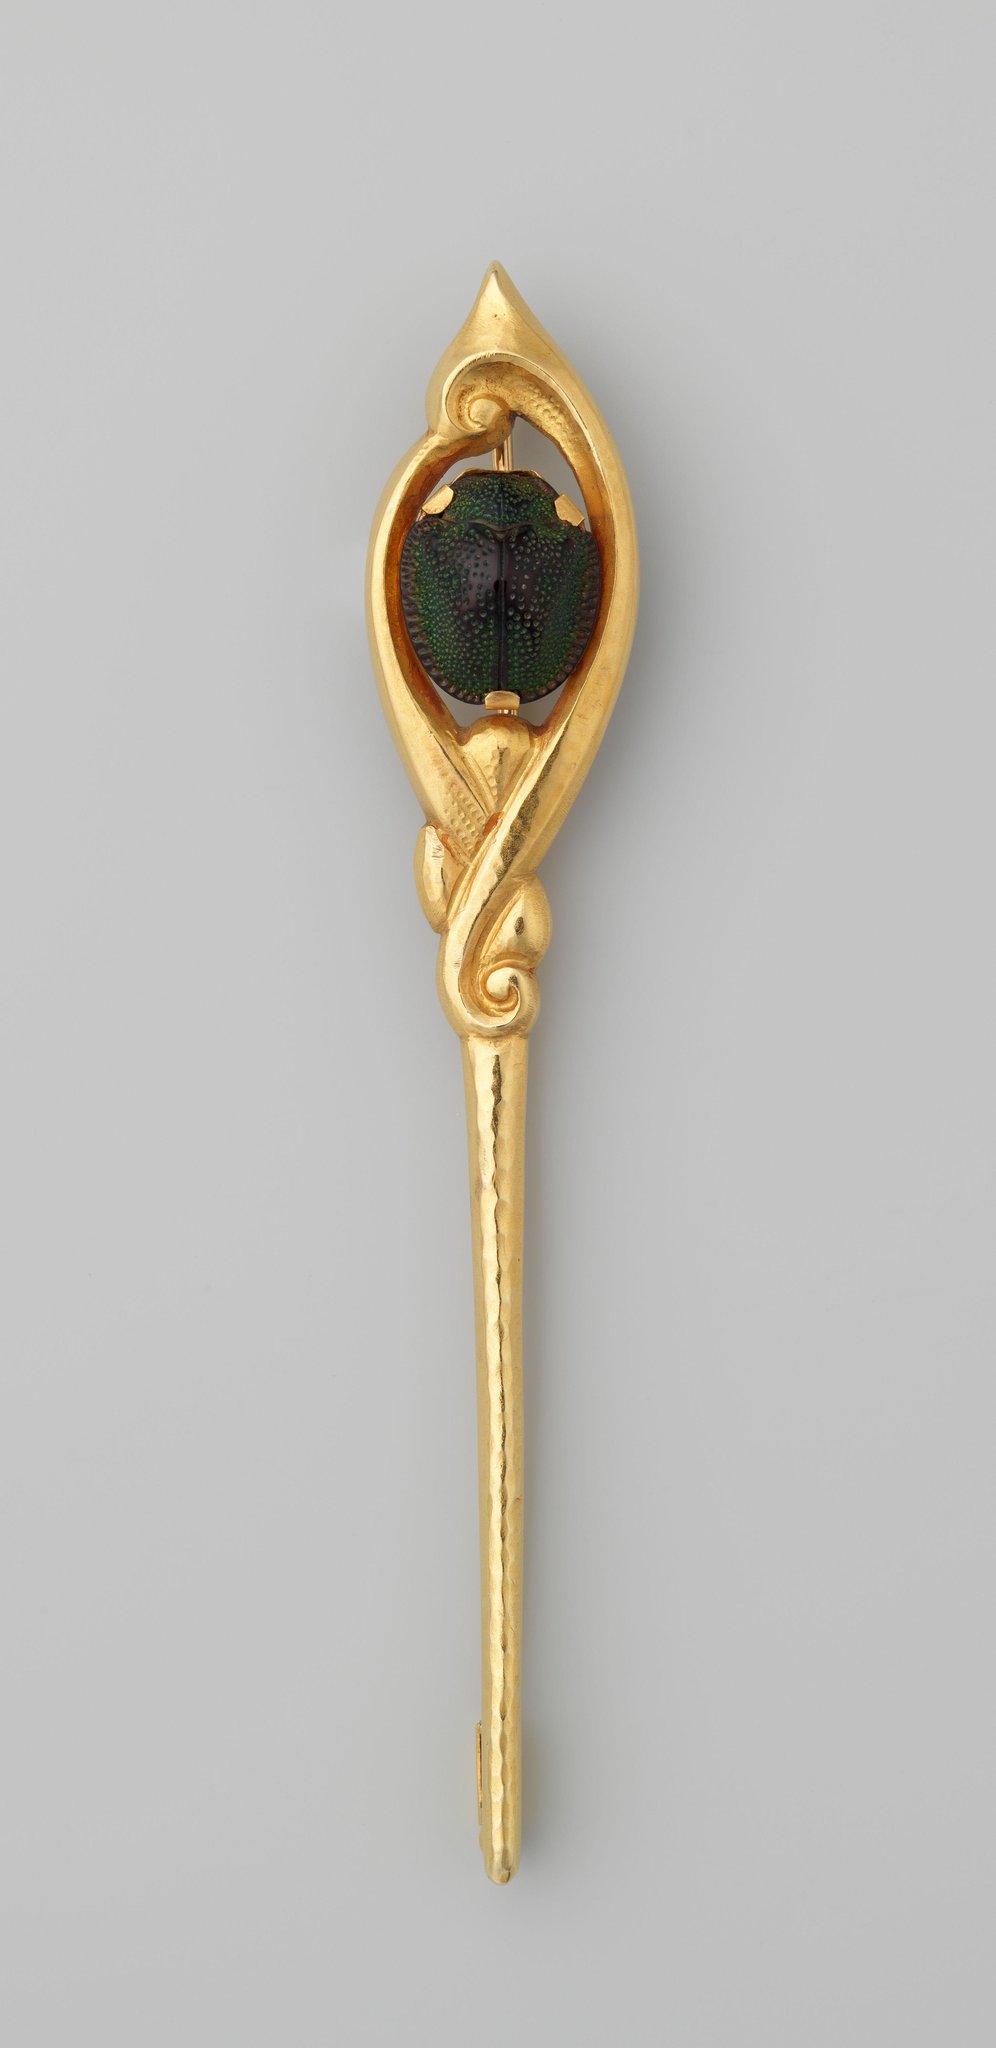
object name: pin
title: Speld van goud met scarabee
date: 1925-1941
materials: gold, gemstone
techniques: repoussé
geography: utrecht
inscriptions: maker's mark: ‘SB met ster’, alloy mark: ‘oud eikenblad’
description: Speld van goud met scarabee met kanonsluiting.